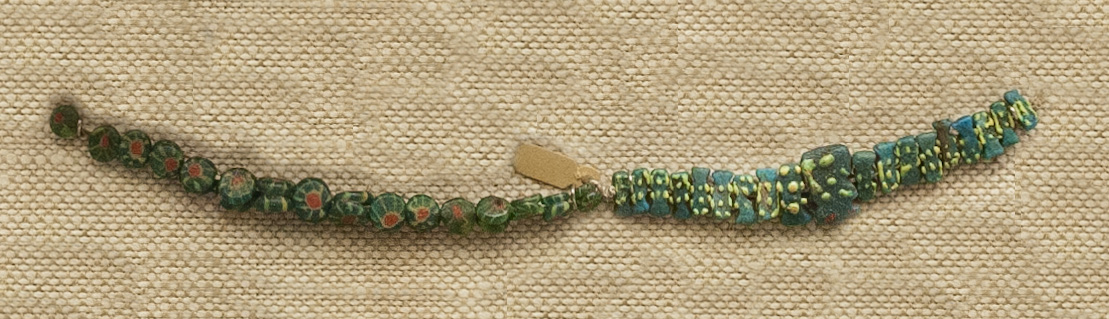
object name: bead, string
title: String of 16 Double Beads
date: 300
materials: glass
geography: egypt